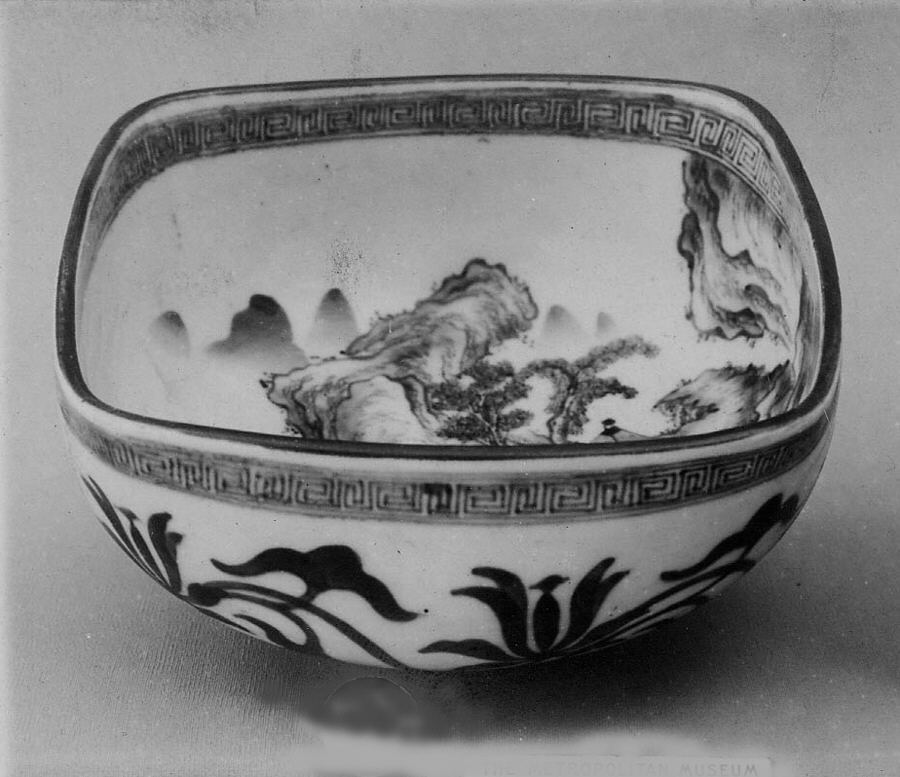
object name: bowl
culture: japanese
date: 1840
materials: glaze, porcelain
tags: leaves